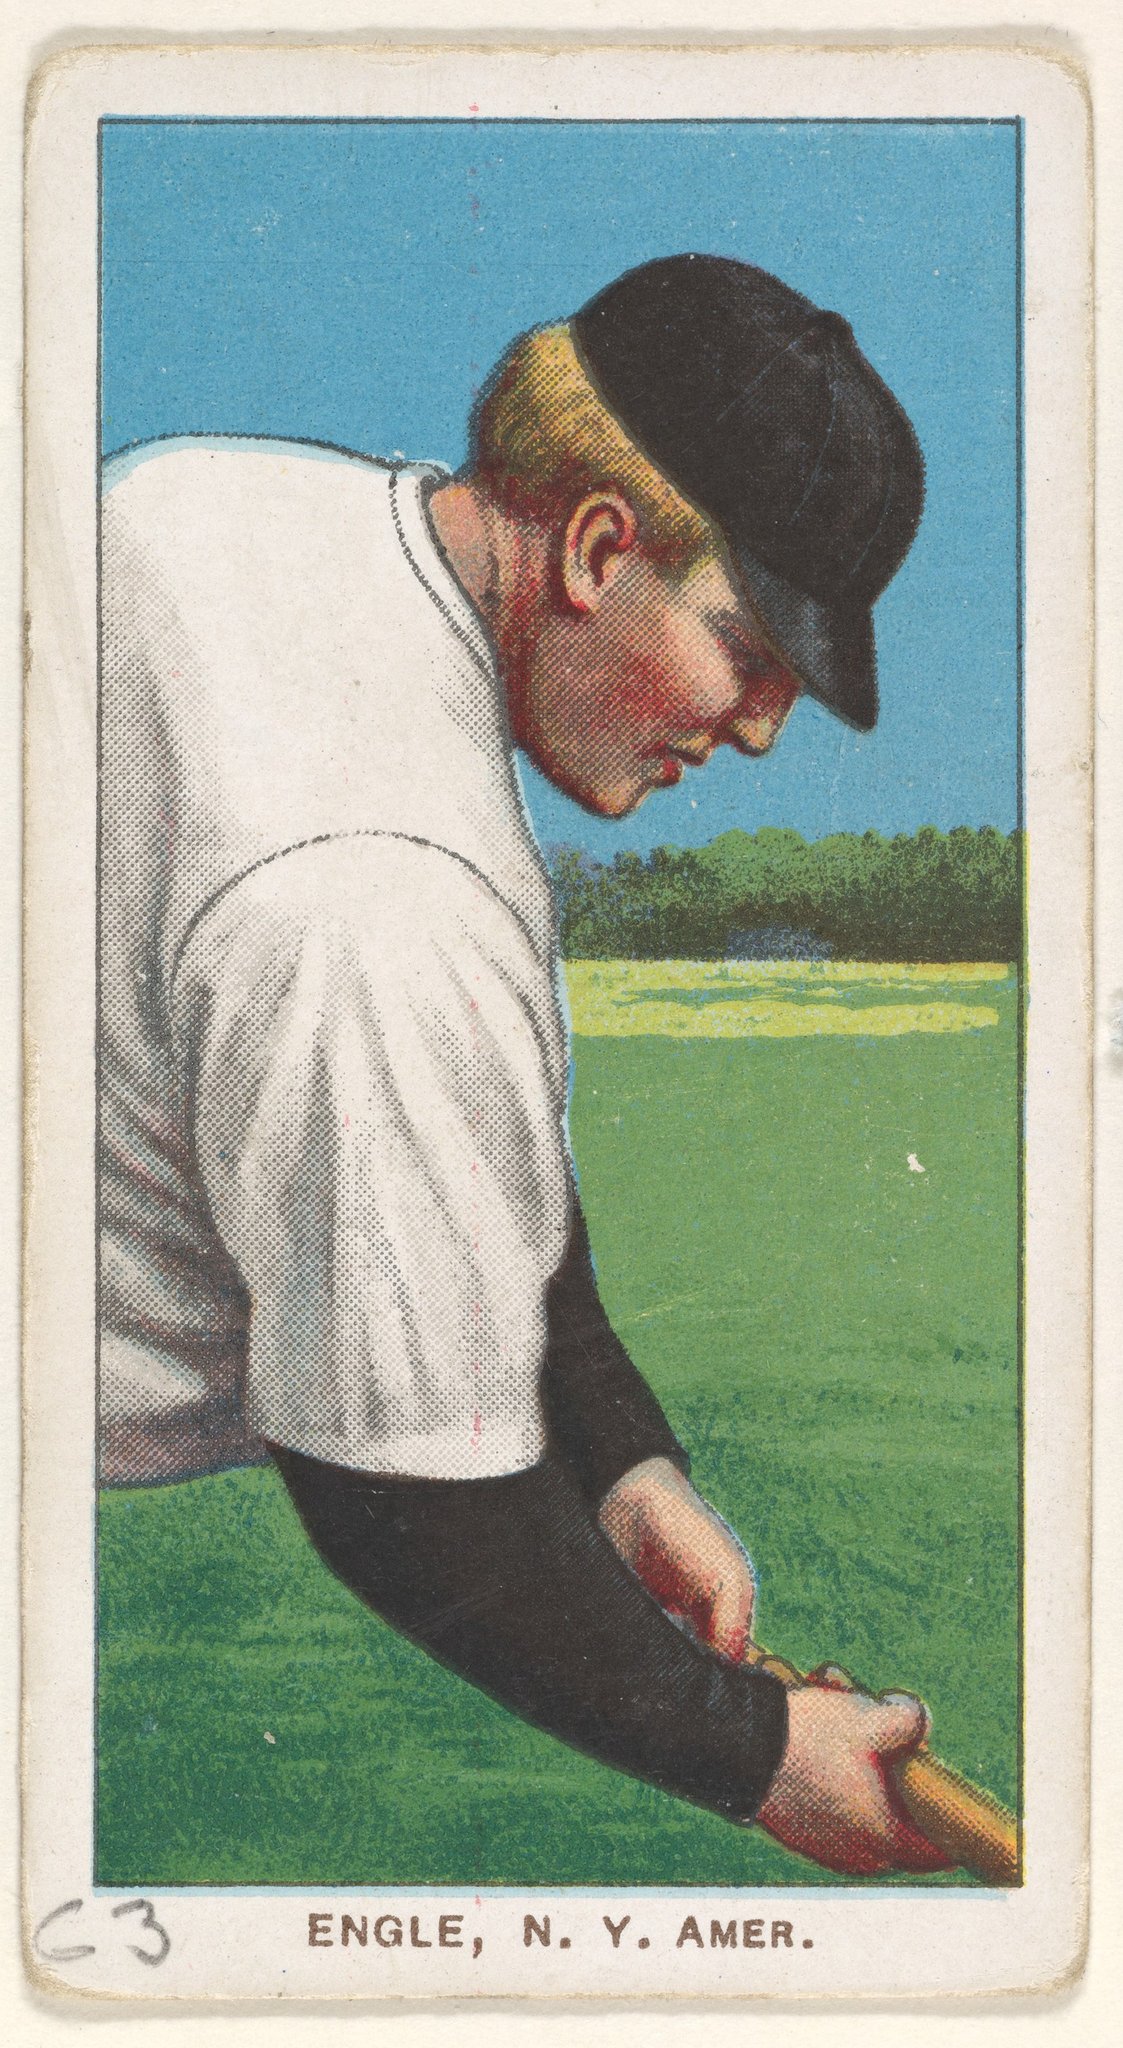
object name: baseball card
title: Engle, New York, American League, from the White Border series (T206) for the American Tobacco Company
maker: american tobacco company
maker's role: publisher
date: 1909-1911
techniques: lithography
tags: men,baseball,athletes